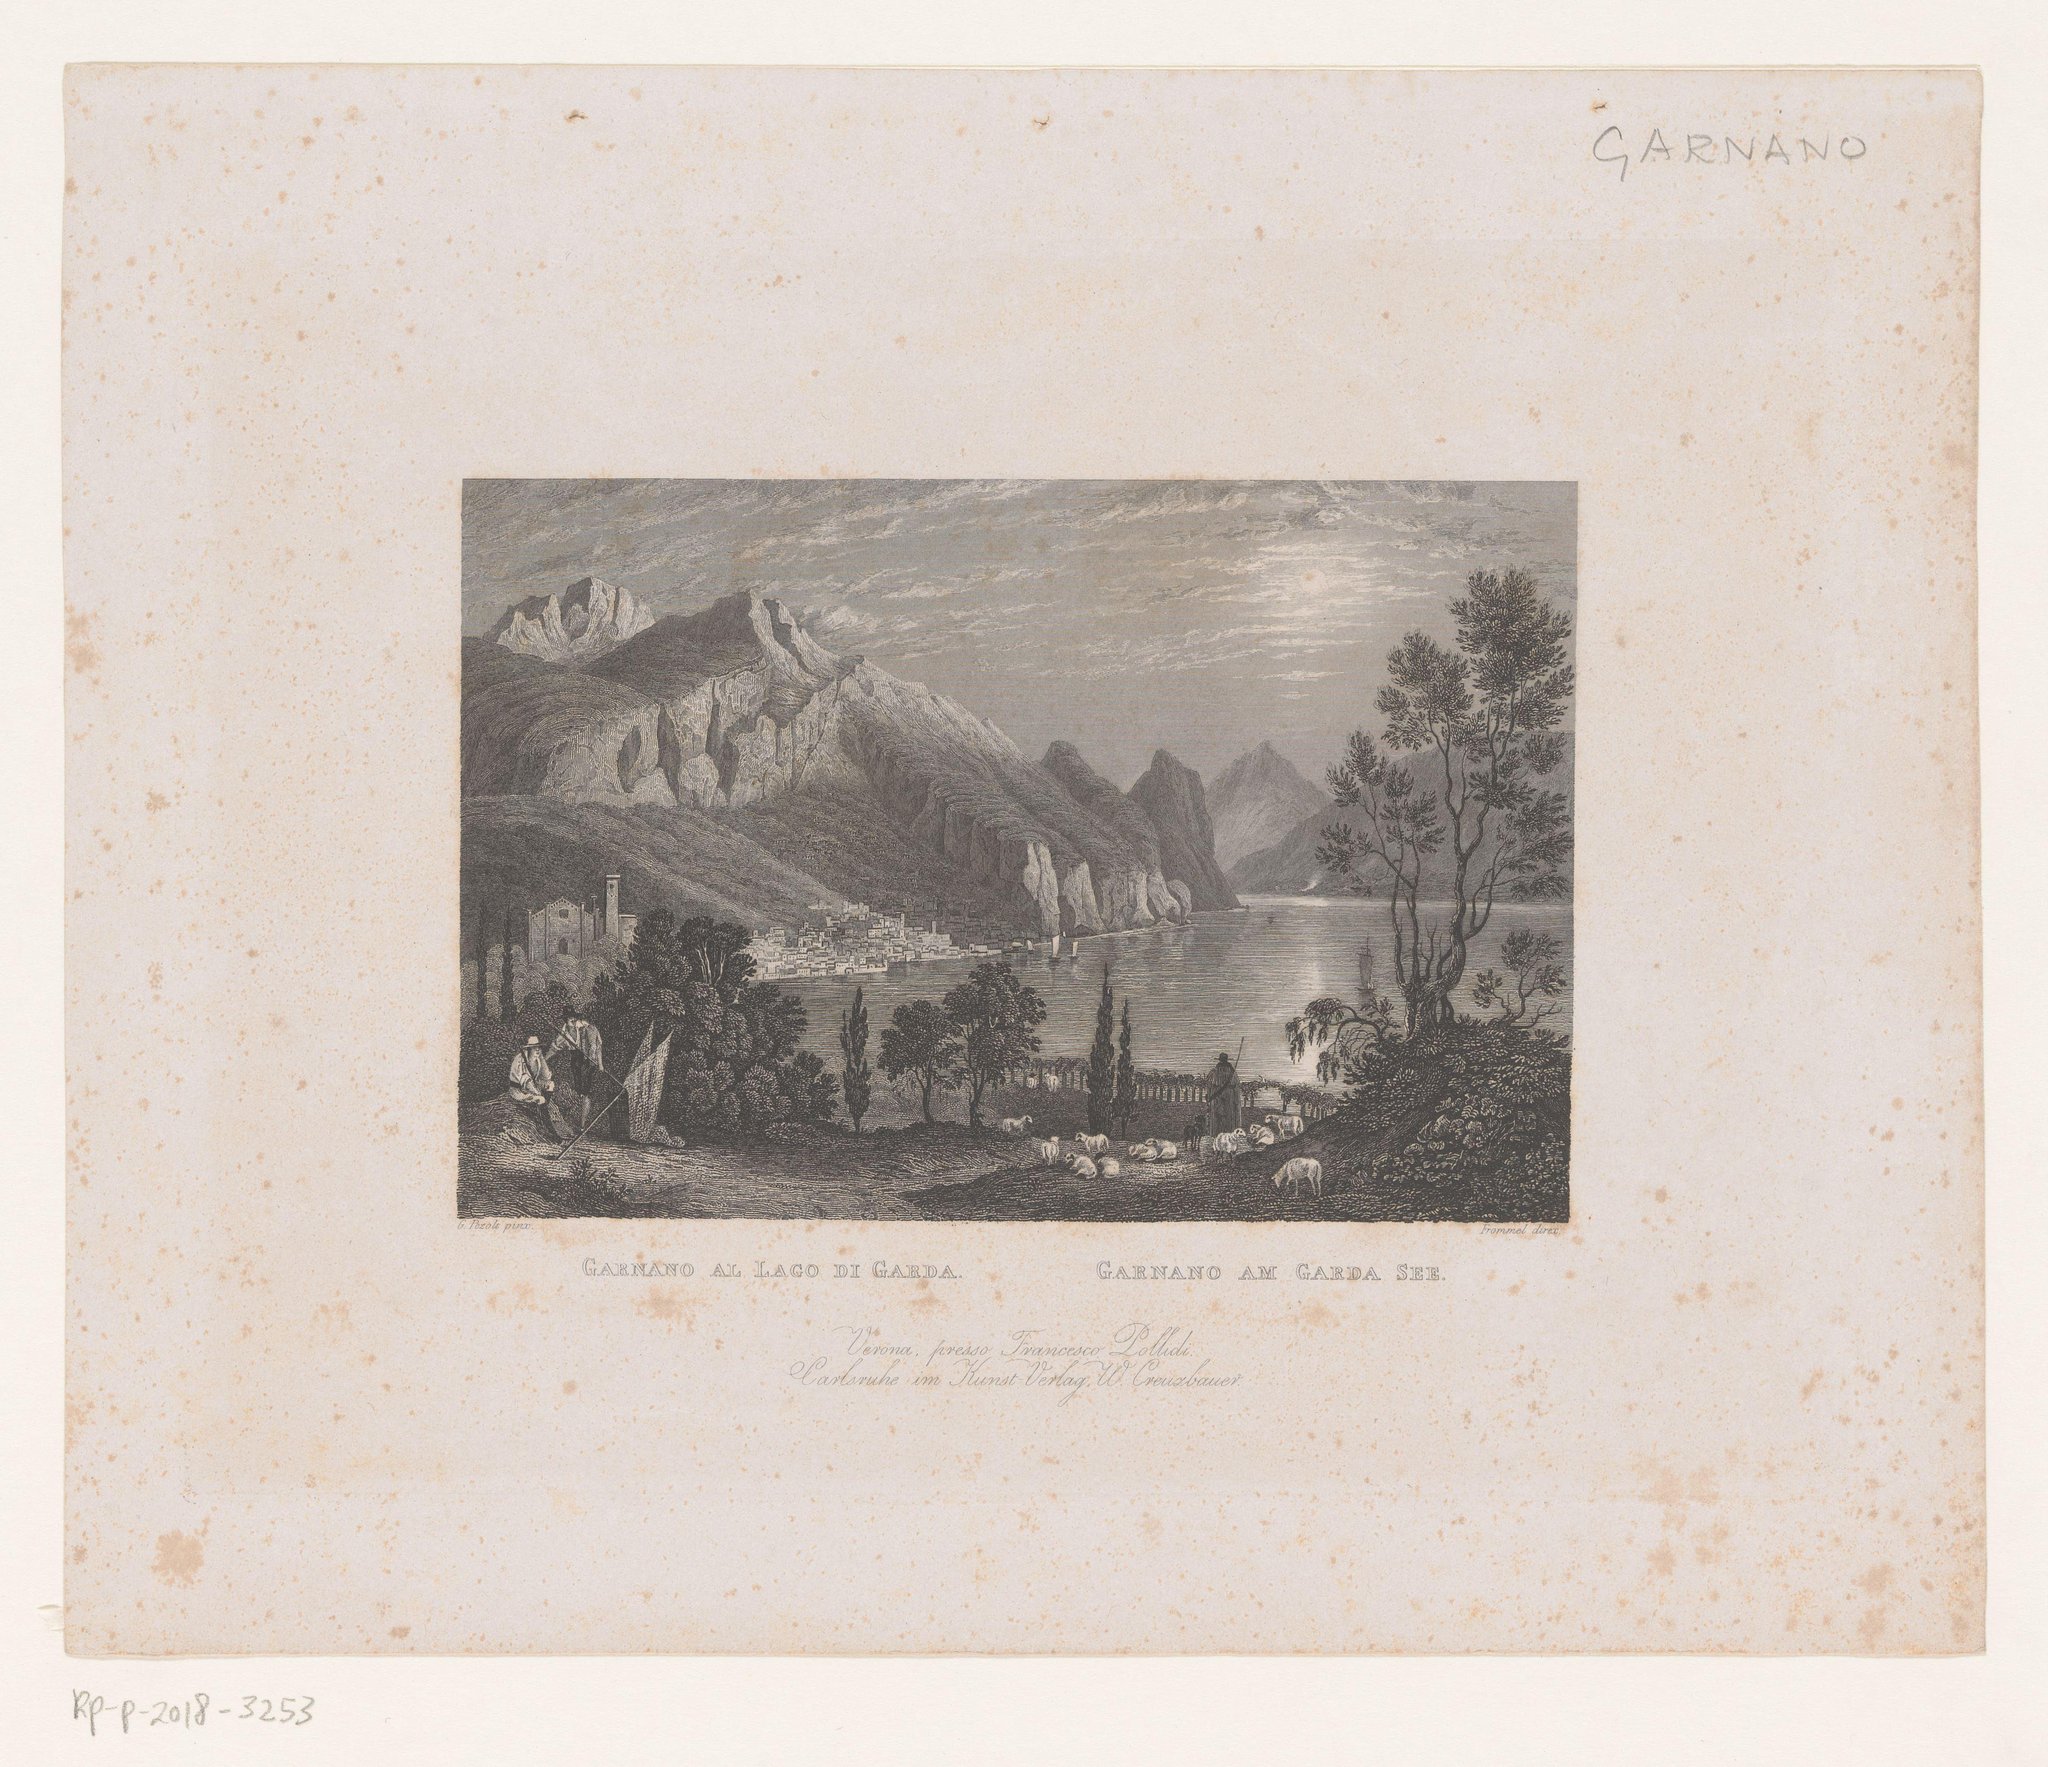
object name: print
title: Garnano al lago di Garda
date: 1835-1860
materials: paper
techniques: engraving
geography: verona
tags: landscapes with waters, waterscapes, seascapes (in the temperate zone), lake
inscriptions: collector's mark: Lugt 2228